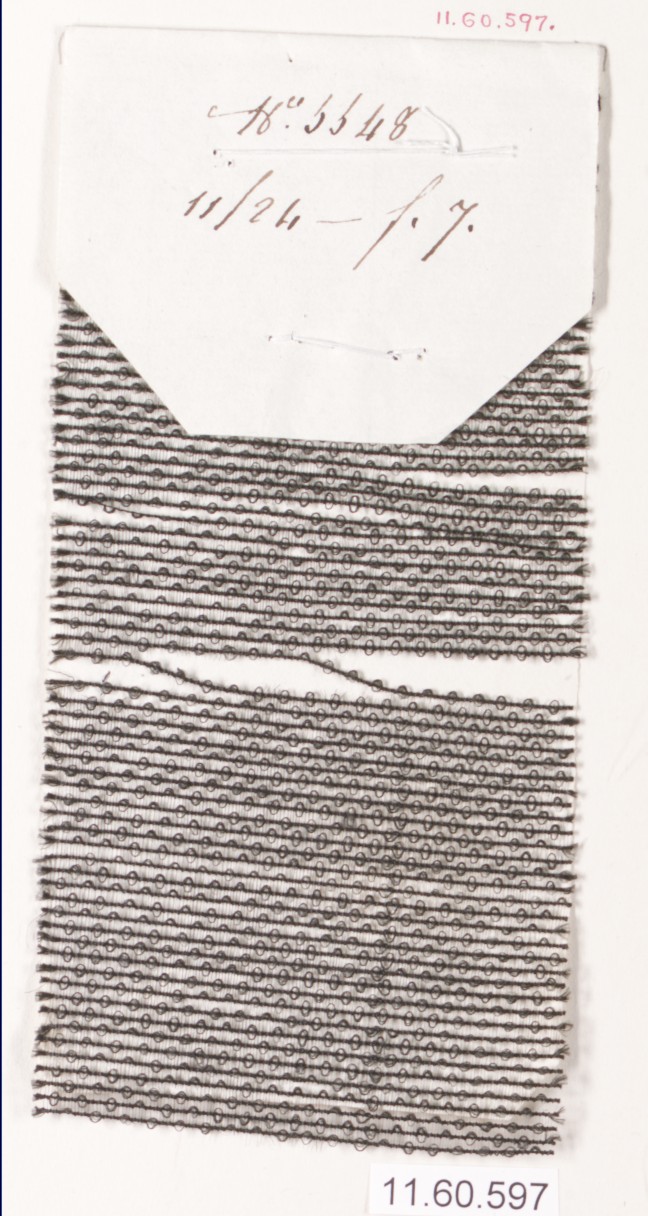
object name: sample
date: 1801-1833